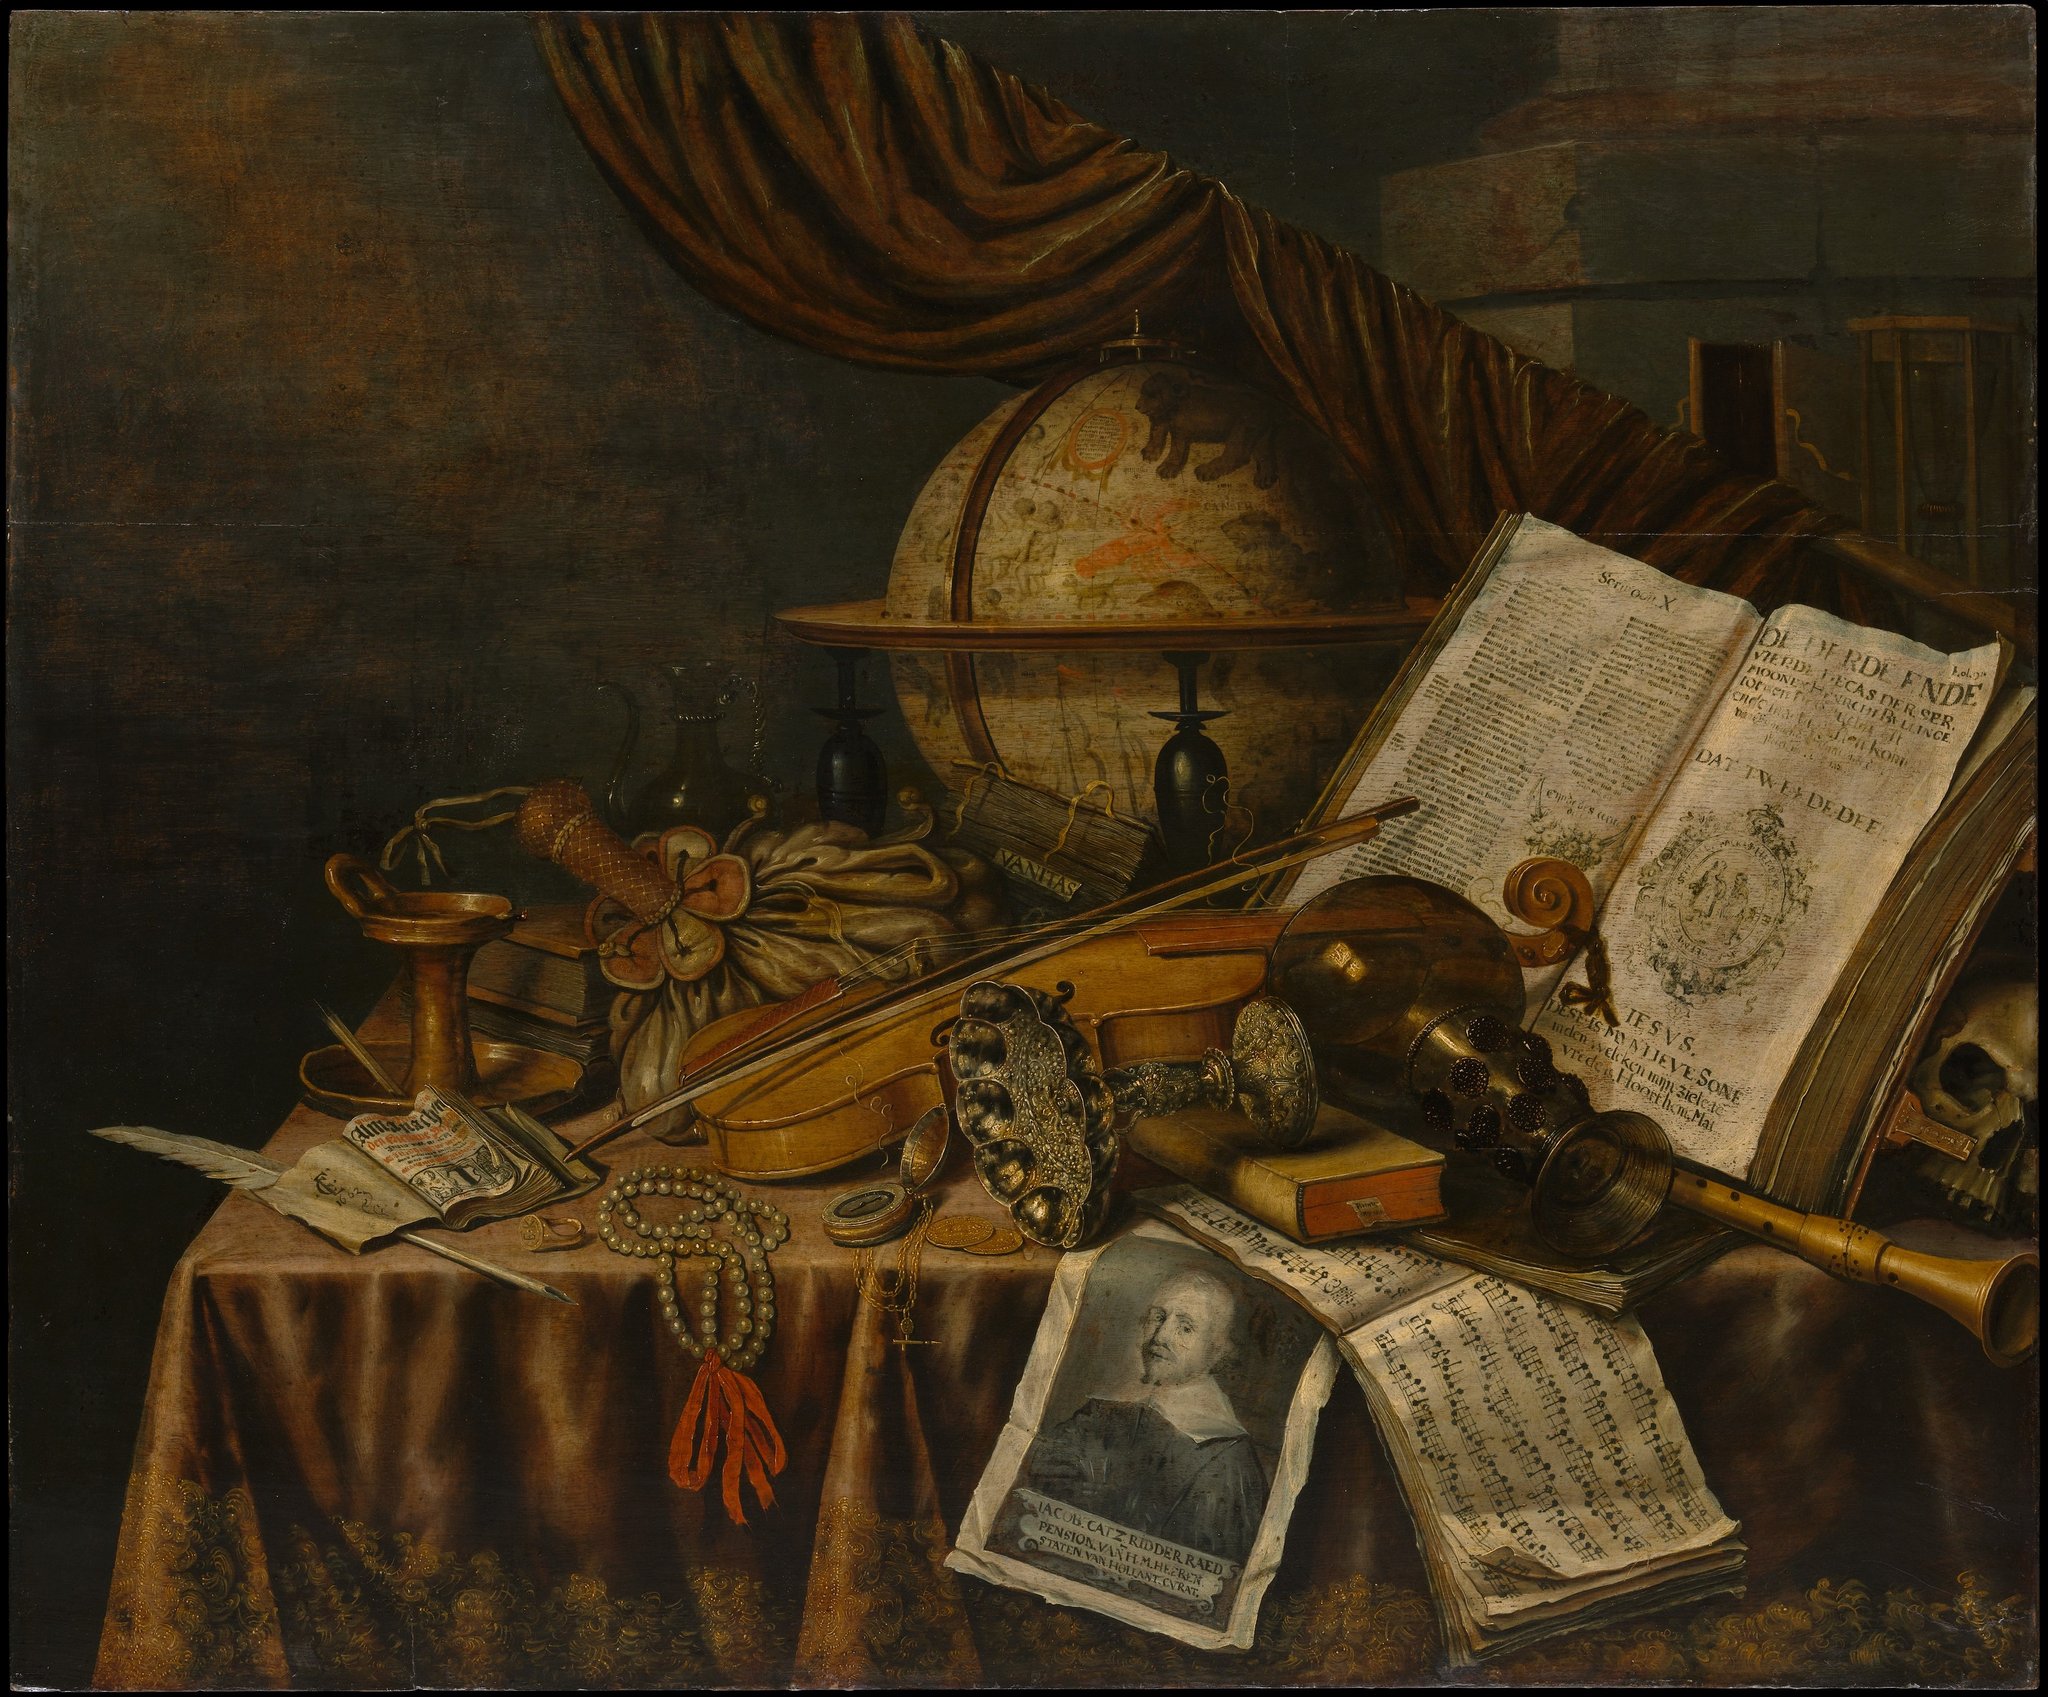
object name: painting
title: Vanitas Still Life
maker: edwaert collier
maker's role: artist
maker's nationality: dutch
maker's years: 1640-1707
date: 1662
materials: oil, wood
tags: books,jewelry,skulls,music,violins,still life,globes